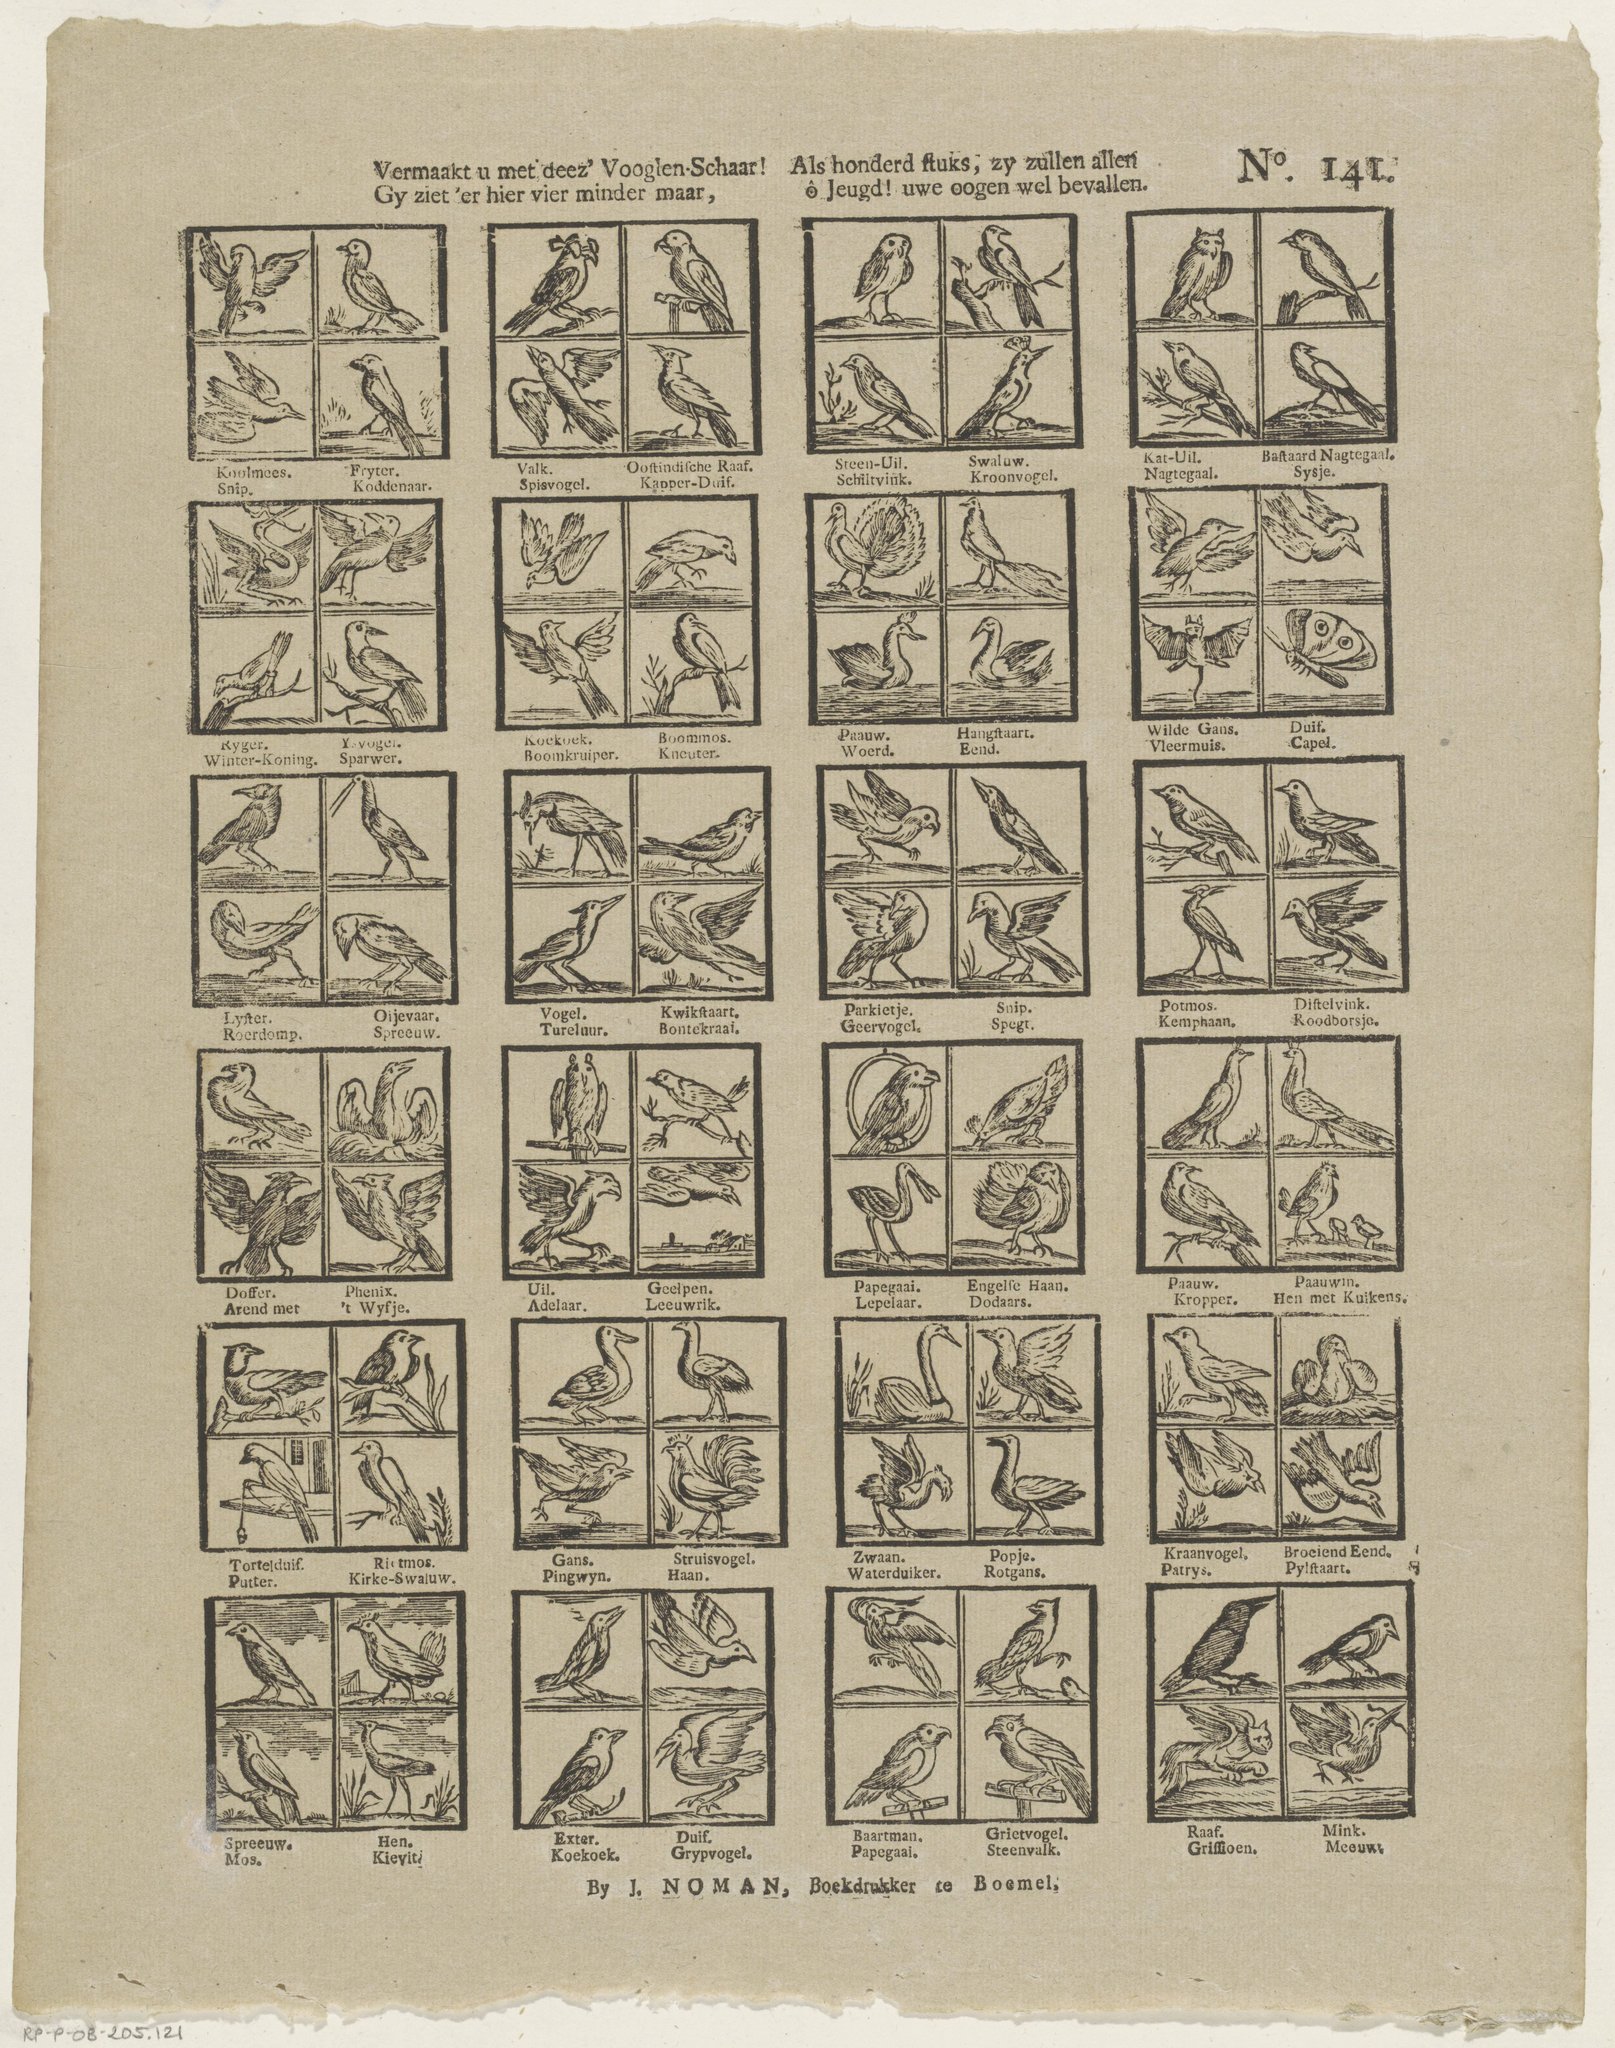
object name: print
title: Vermaakt u met deez' vooglen schaar! / Gy ziet 'er hier vier minder maar, / Als honderd stuks, zy zullen allen / ô jeugd! uwe oogen wel bevallen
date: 1806-1830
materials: paper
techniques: letterpress printing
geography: netherlands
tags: flying mammals: bat, birds, insects: butterfly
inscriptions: collector's mark: Lugt 2760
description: Blad met 24 voorstellingen met elk vier gevleugelde dieren, zoals vogels, een uil, een vleermuis en een vlinder, de zgn. Groote Vogelkooi. Onder elke voorstelling de namen van de dieren. Genummerd rechtsboven: No. 141.